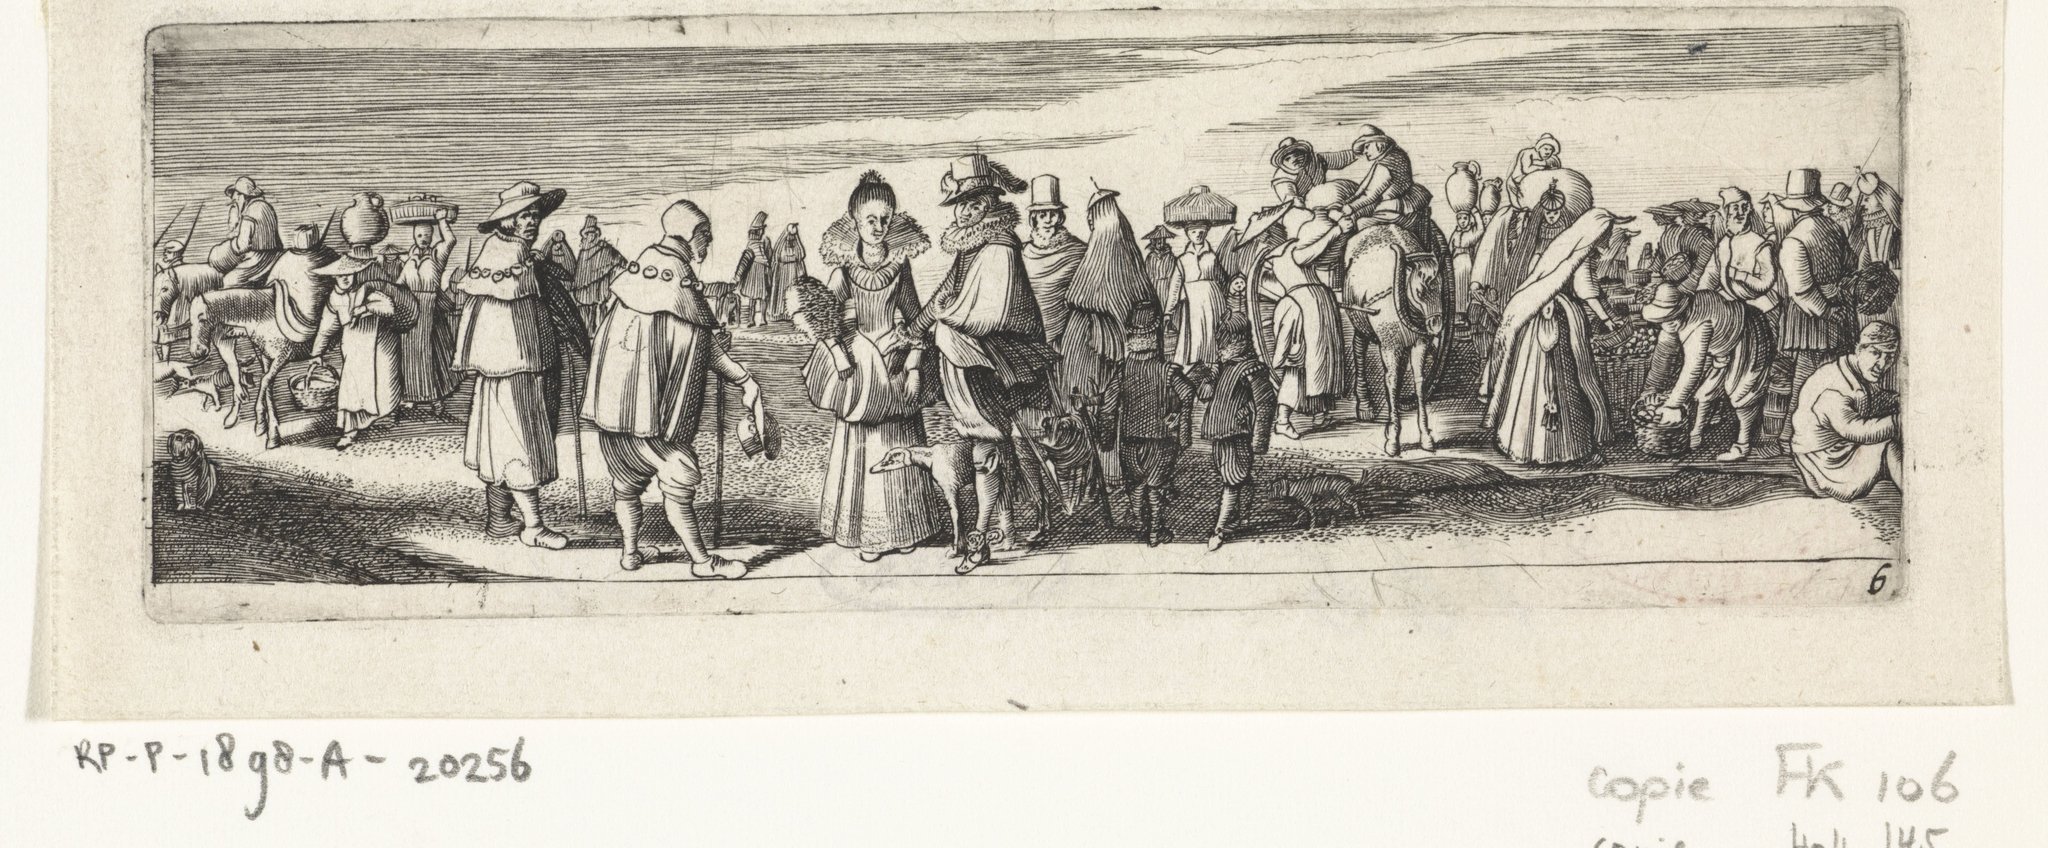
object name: print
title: Markt, kleine kopiëen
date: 1603-1652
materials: paper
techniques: engraving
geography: amsterdam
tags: pilgrim(s), cape (huik) (+ women's clothes), market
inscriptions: collector's mark: Lugt 964, collector's mark: Lugt 240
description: Een groepje elegant geklede burgers, voor wie twee pelgrims, op een markt. Een van hen vraagt een aalmoes. Rechts een vrouw met huik, bij een mand met fruit. Daarnaast wordt een kar uitgeladen. Zesde prent uit een serie van zes.